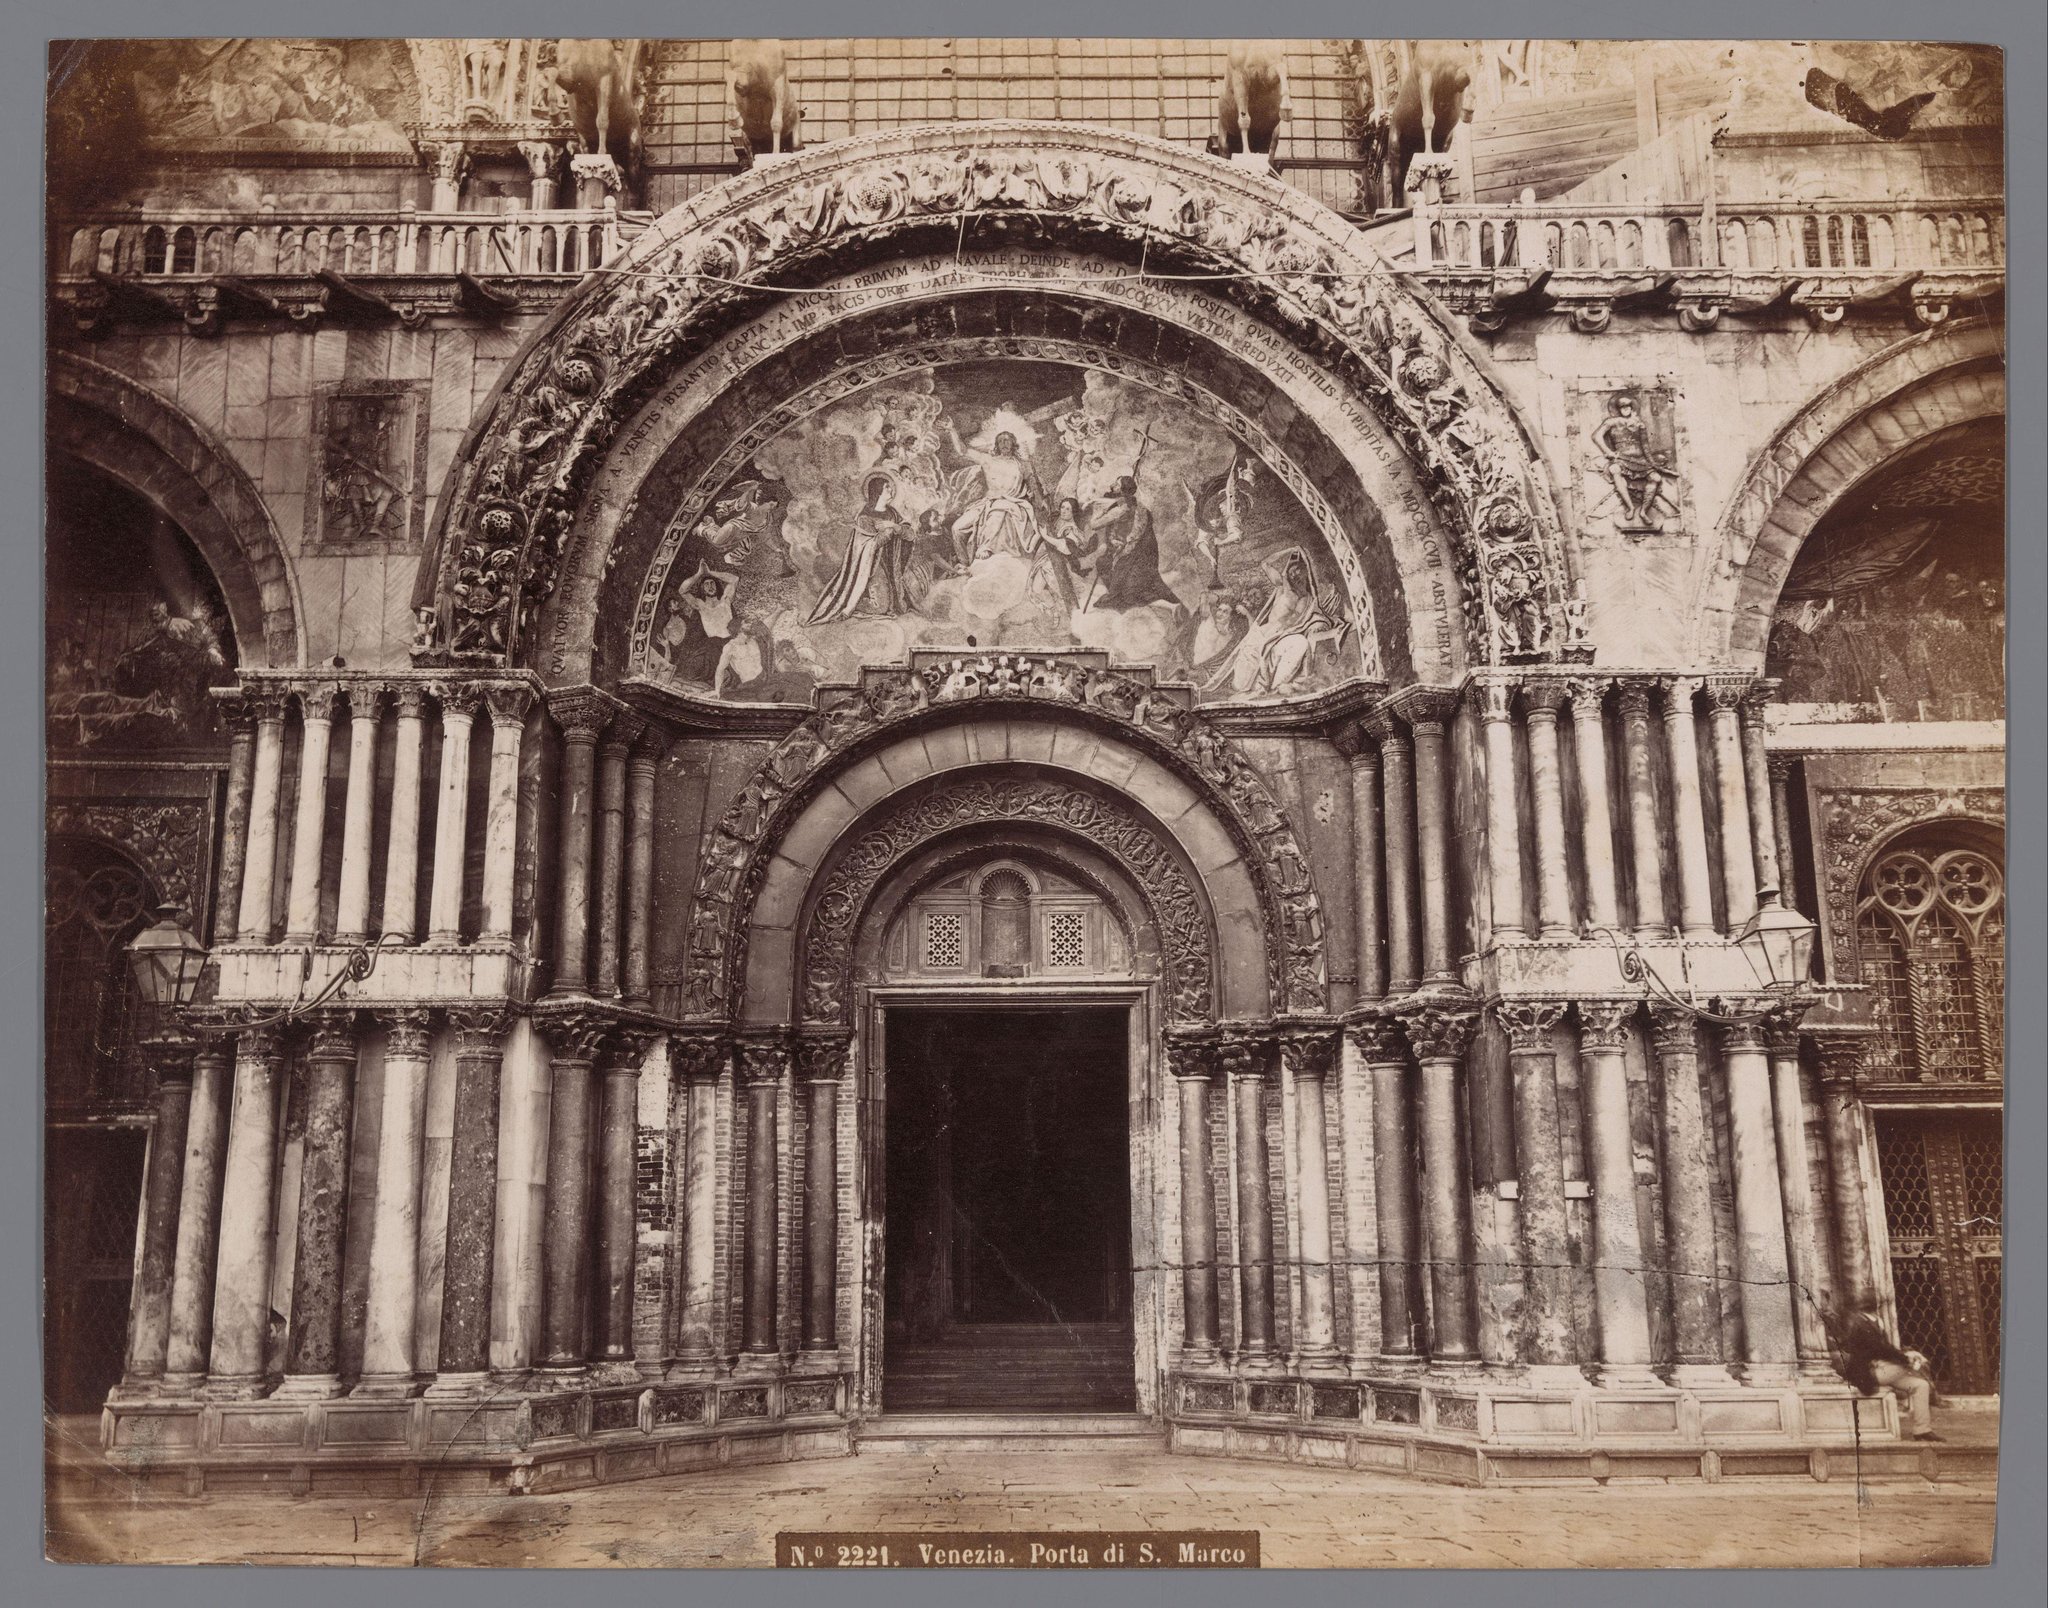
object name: photograph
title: Hoofdportaal van de San Marco te Venetië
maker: Anonymous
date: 1851-1900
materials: paper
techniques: albumen print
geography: venice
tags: parts of church exterior and annexes: portal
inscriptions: number: ‘No. 2221.’